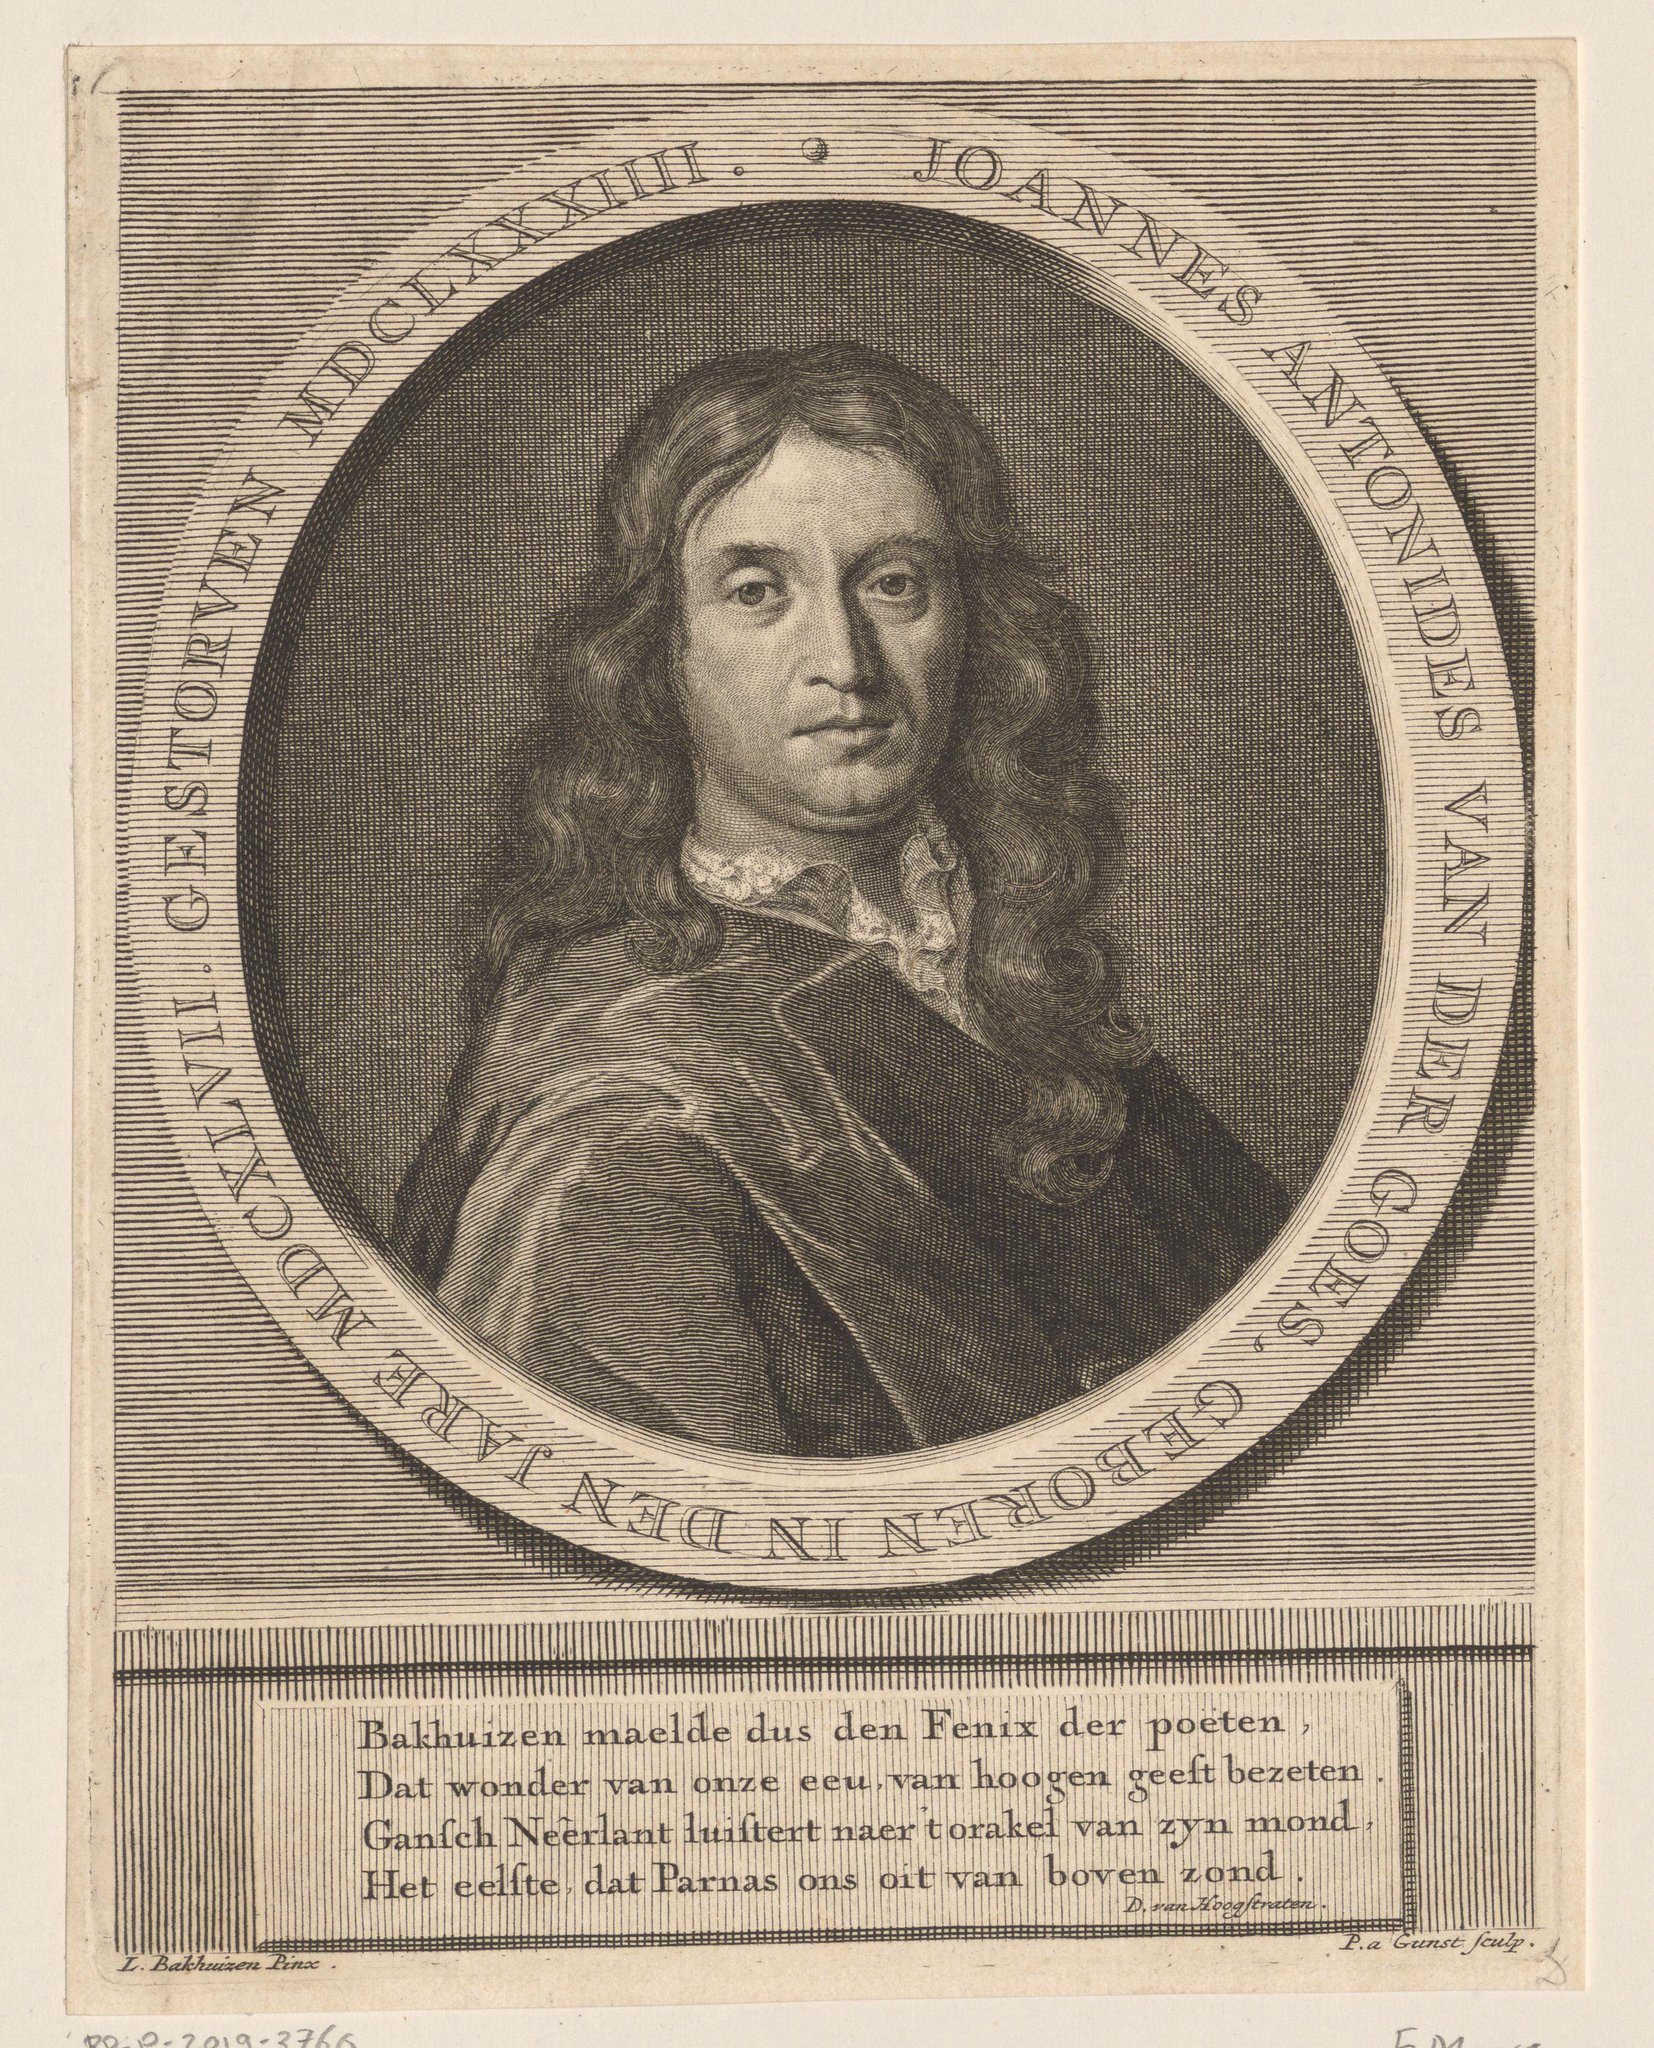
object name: print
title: Portret van Jan Antonides van der Goes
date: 1714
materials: paper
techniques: engraving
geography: amsterdam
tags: rotterdam, jan antonides van der goes, historical persons, portrait of a writer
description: Prent uit: Antonides van der Goes, Jan. Alle de gedichten. Amsterdam: Nicolaas ten Hoorn, 1714.